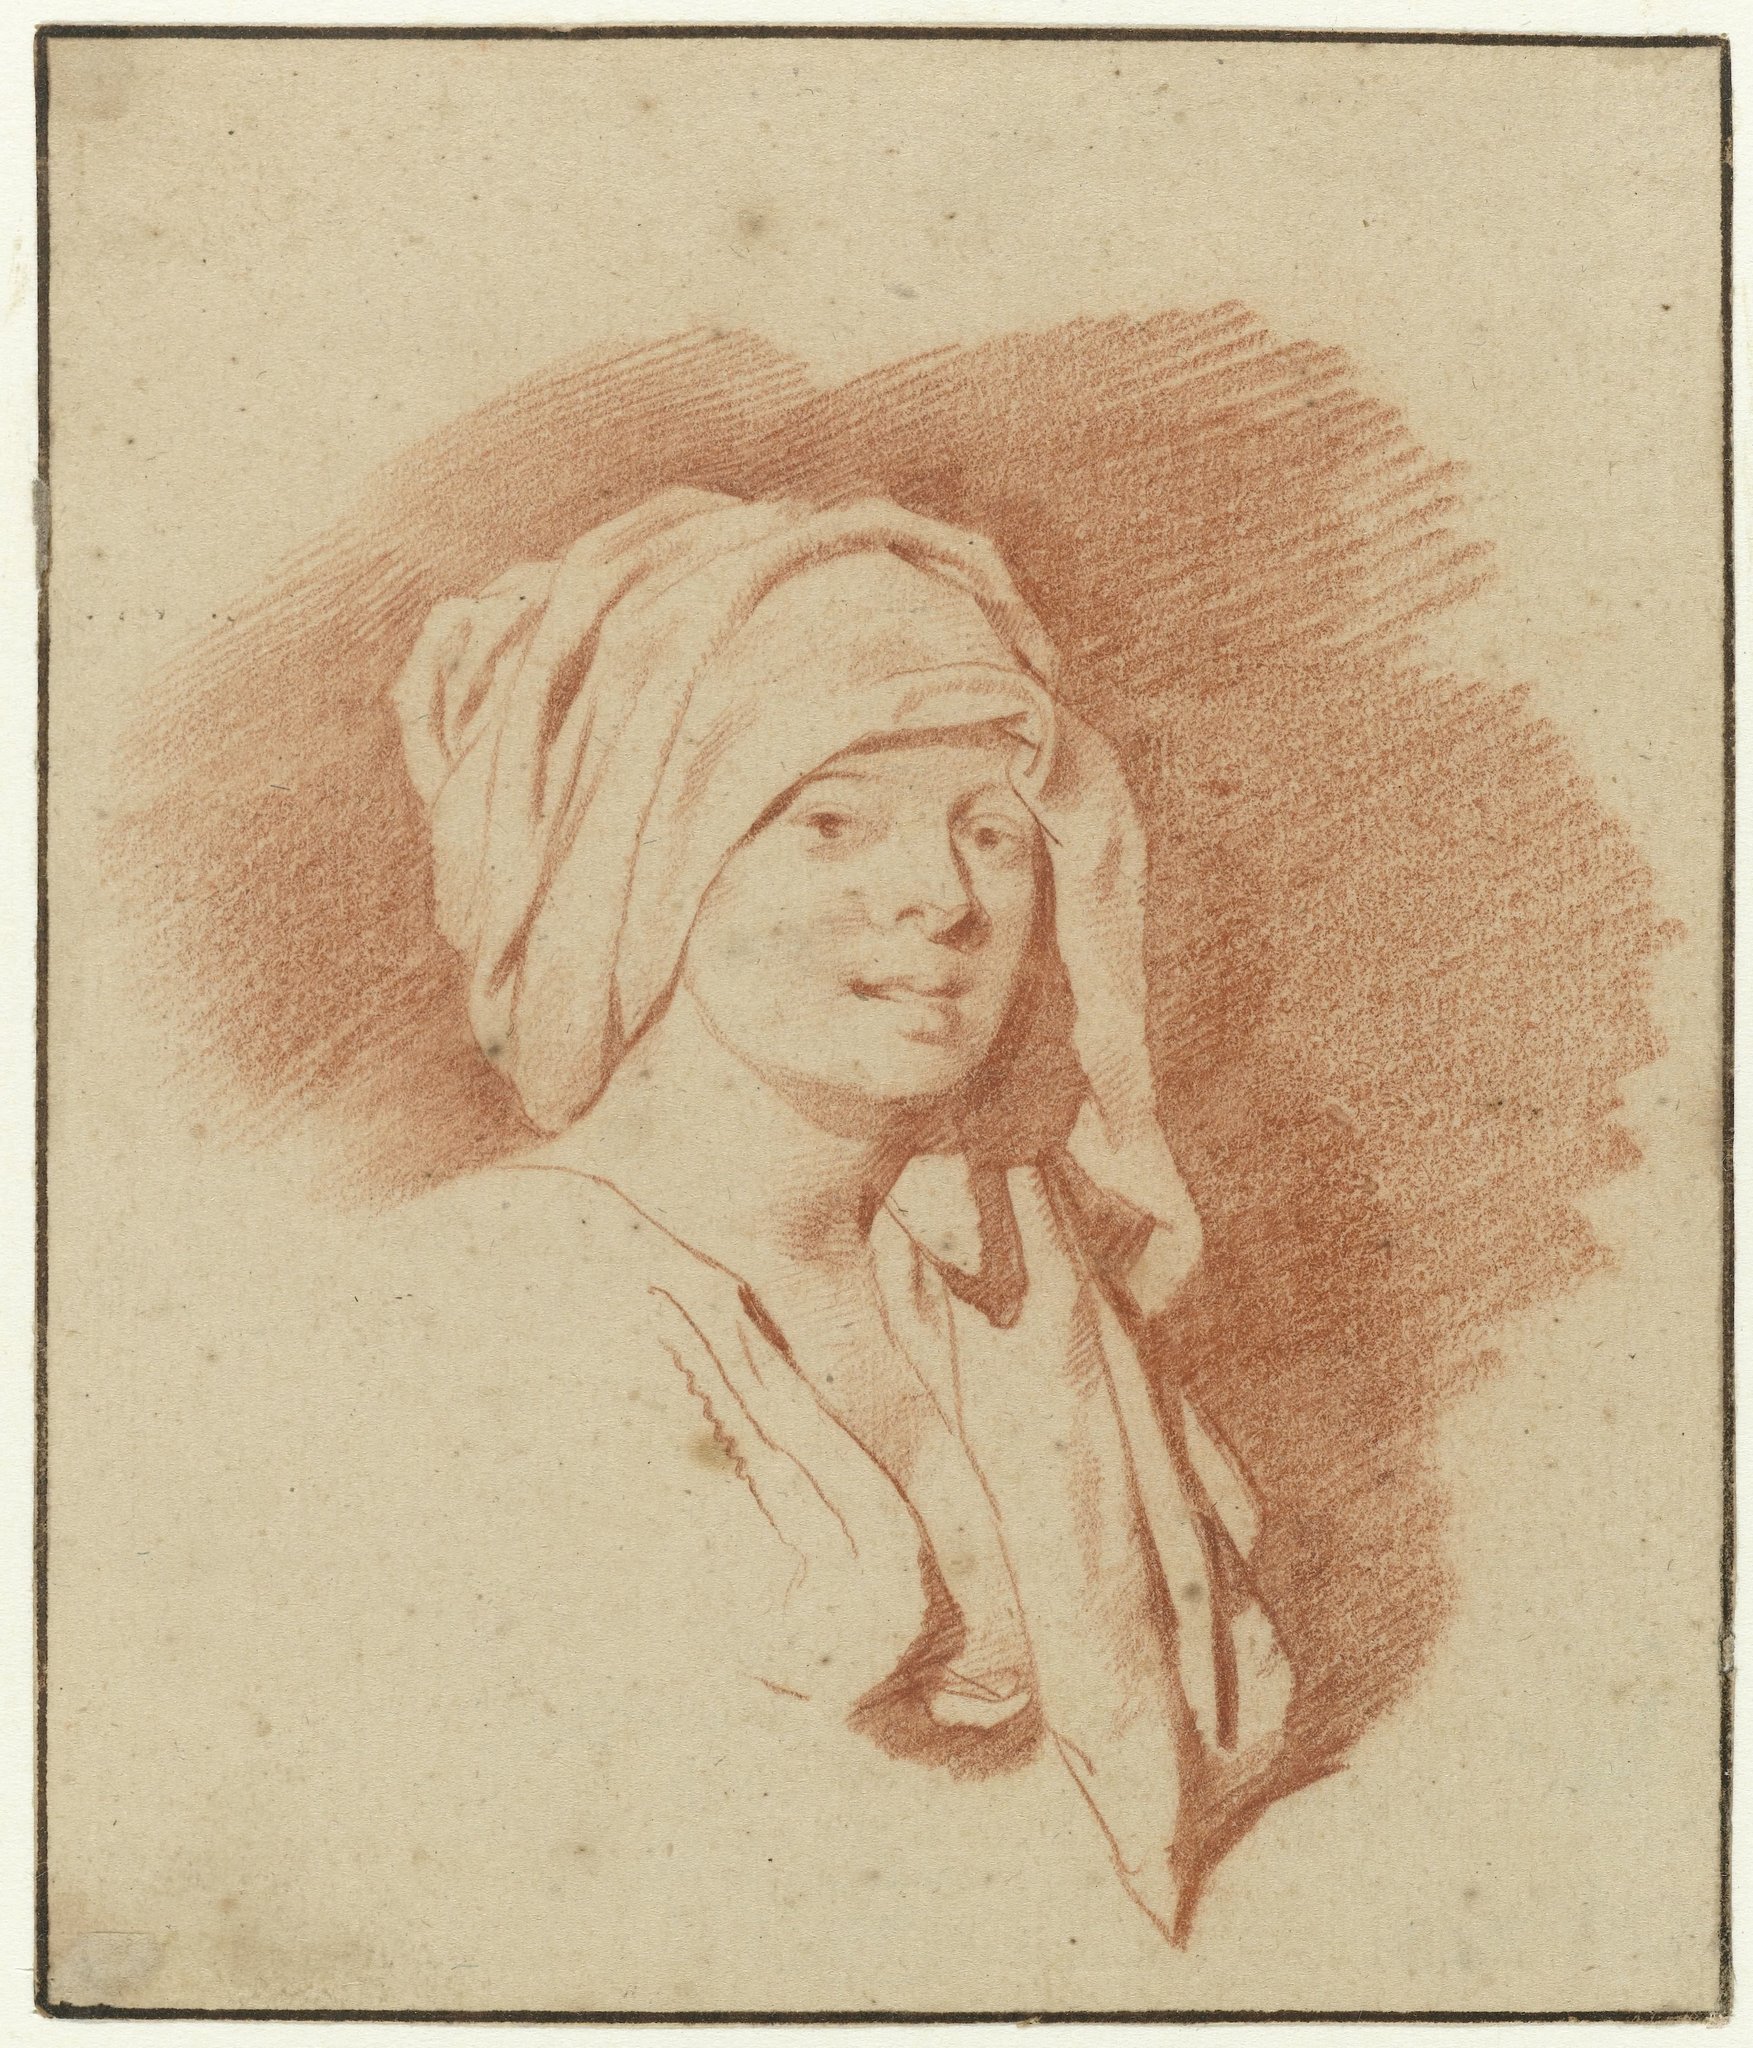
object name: drawing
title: Study of a Woman, Bust Length, Wearing a Headdress, Facing Right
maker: cornelis pietersz. bega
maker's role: draughtsman, painter, print maker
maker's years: 1631-1664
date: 1660-1662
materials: chalk, paper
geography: haarlem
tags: head (human) - aa - female human figure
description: Borstbeeld van een vrouw met een doek om het hoofd, die tot op de borst hangt.